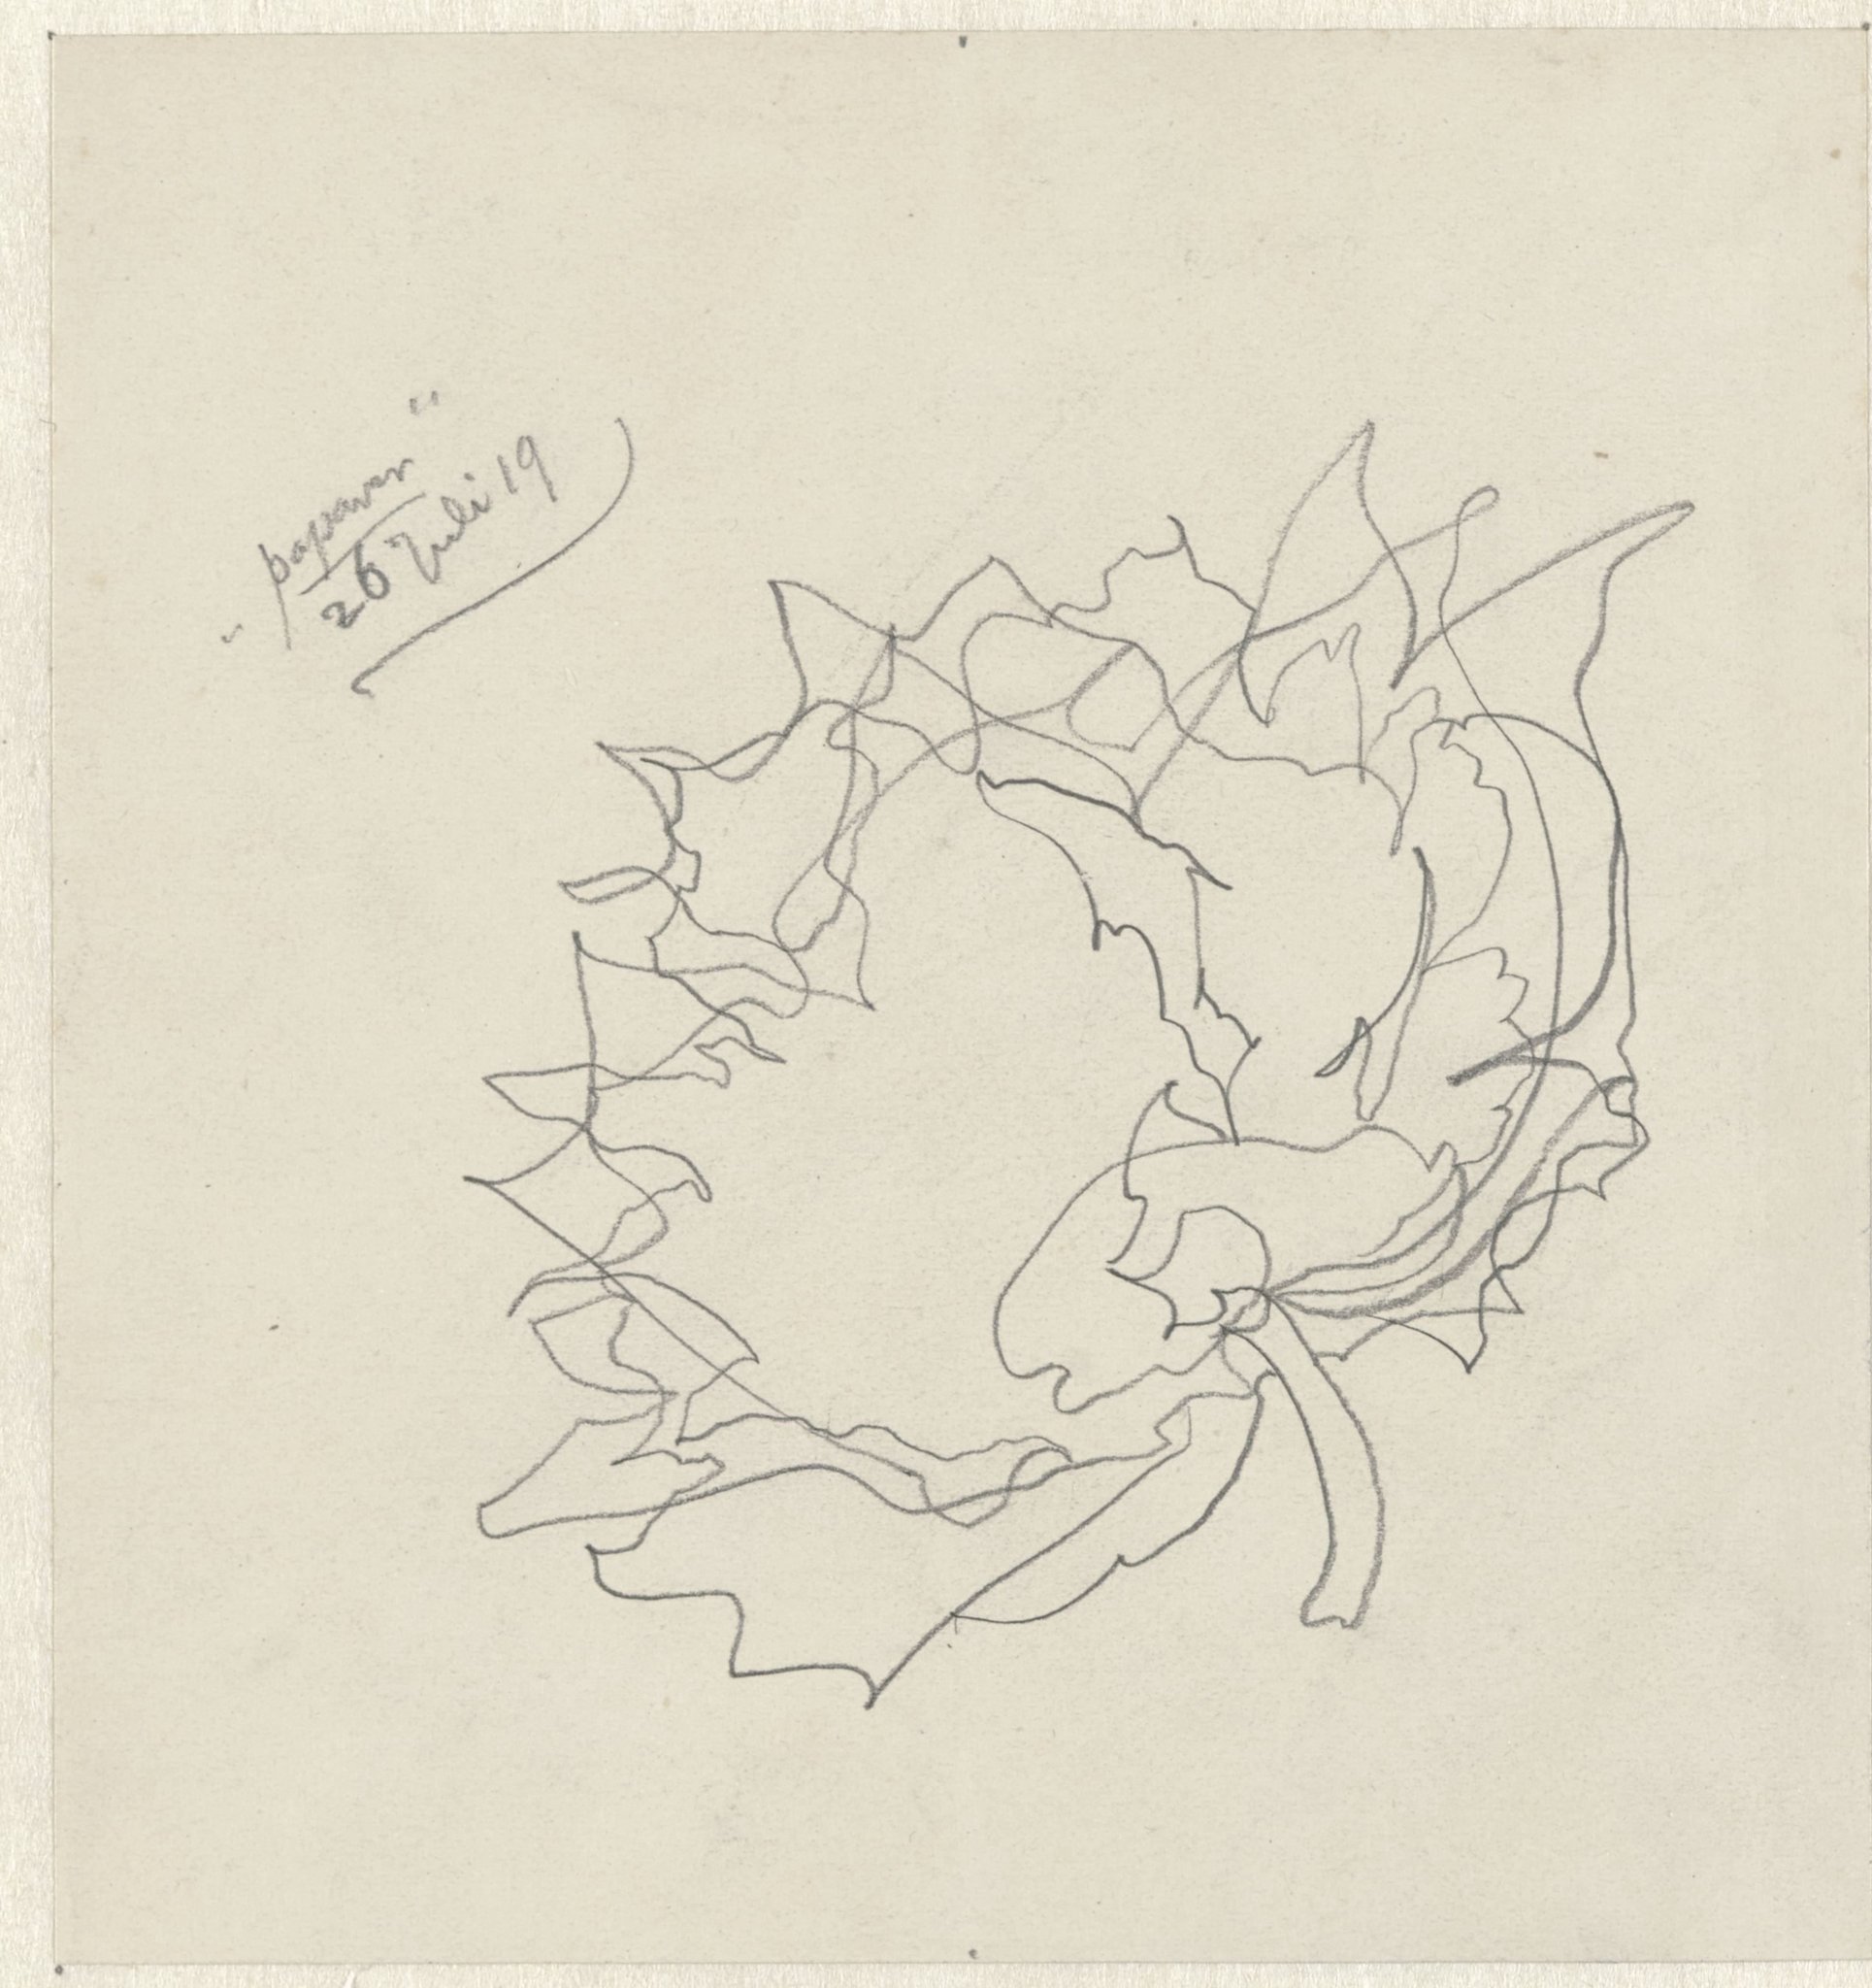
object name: design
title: Ontwerp voor aardewerkdecoratie: papaver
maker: theo colenbrander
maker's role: draughtsman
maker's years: 1841-1930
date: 1919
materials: paper, pencil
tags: flowers: poppy, flowers ~ ornament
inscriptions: date: ‘26 Juli 19’